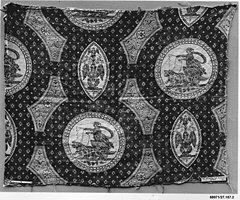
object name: piece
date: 1801-1900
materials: linen